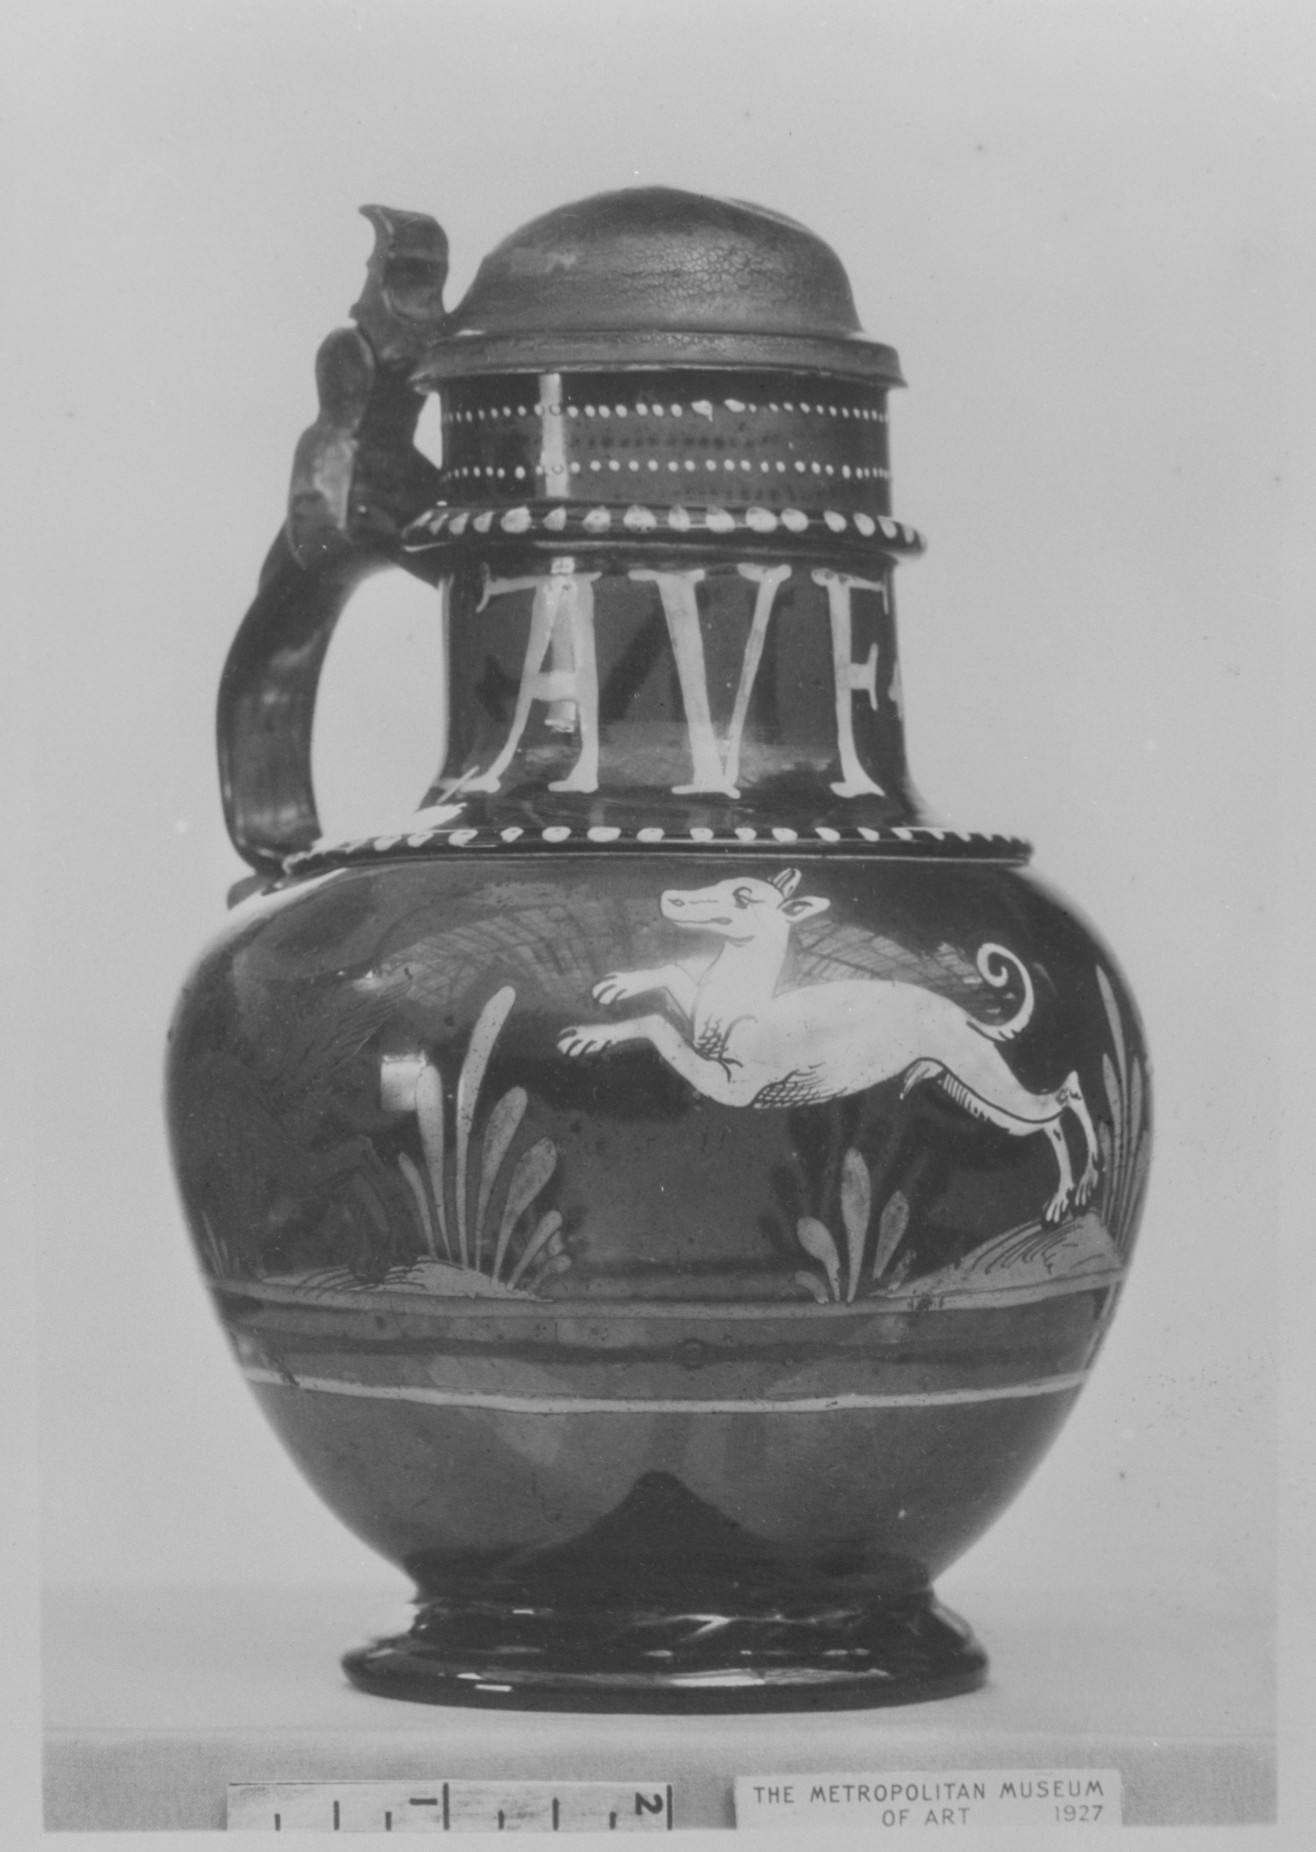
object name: jug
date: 1590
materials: glass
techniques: enamel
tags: animals